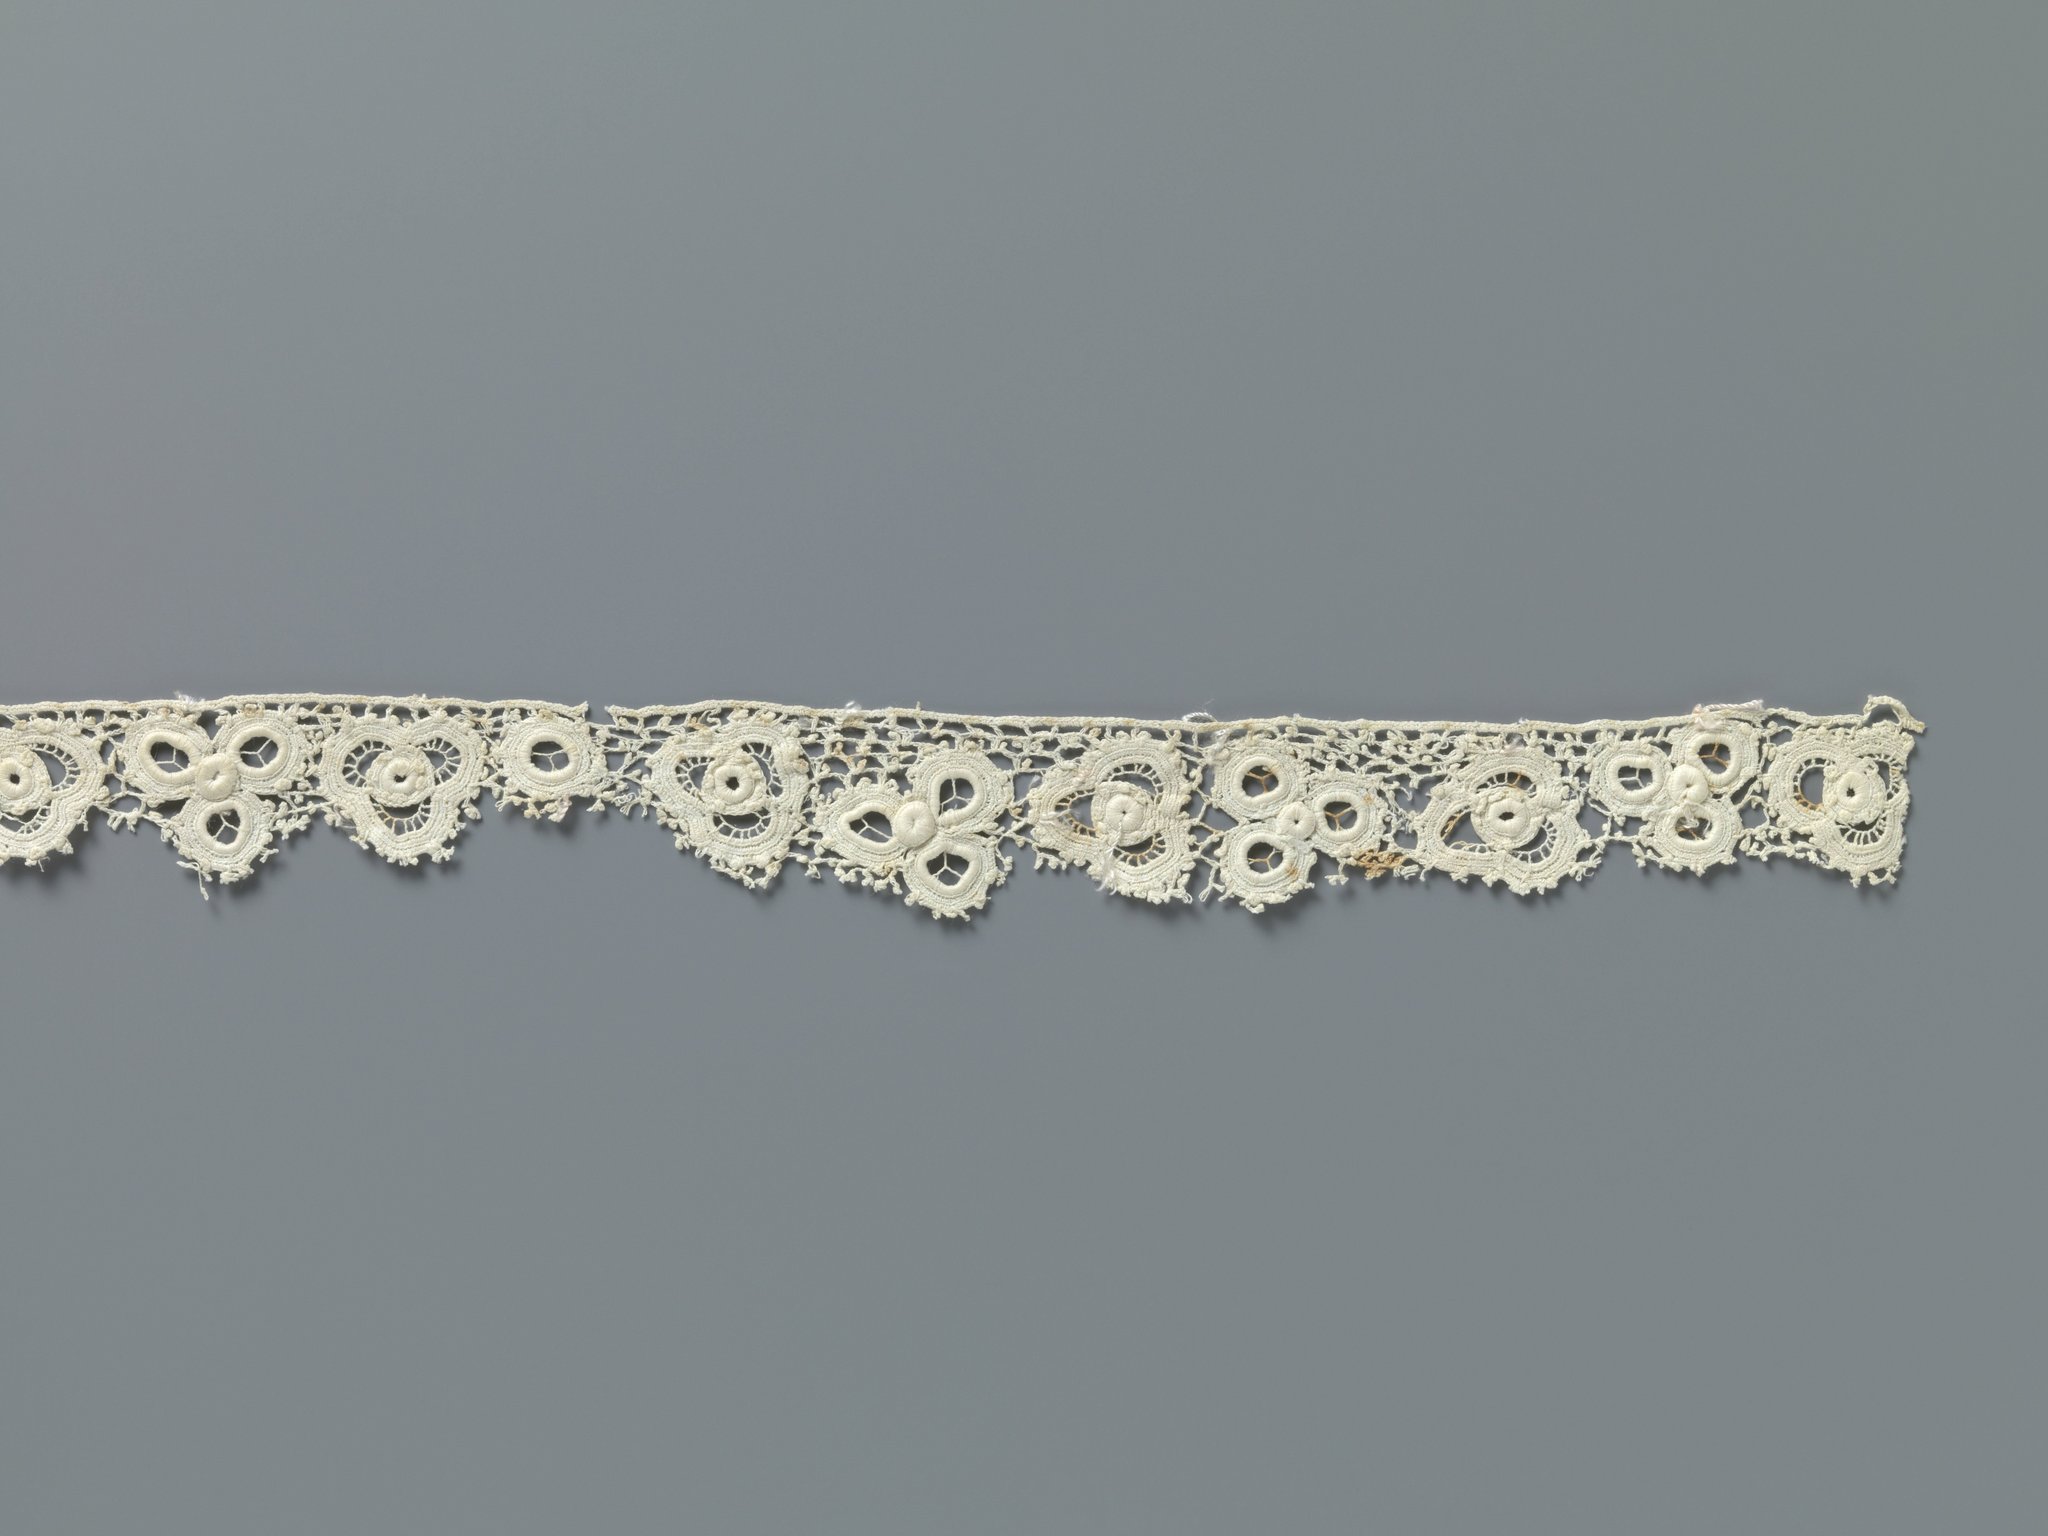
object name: strip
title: Strook gehaakte kant met driehoekig bloemmotief gemaakt met open cirkels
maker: Anonymous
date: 1890-1909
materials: cotton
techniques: crocheted lace, irish crochet lace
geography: ireland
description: Het is een aanname dat deze Ierse gehaakte kant ook daadwerkelijk in Ierland is gemaakt. Ierse gehaakte kant kent zijn oorsprong rond 1760 en kwam vanaf 1840 in ontwikkeling. Aangezien volgens Martine Bruggeman (Kant in Europa) de Ierse haakindustrie aan het eind van de 19e eeuw gereorganiseerd werd en in populariteit groeide, is het hier beschreven stuk gedateerd rond 1890, tot 1909 vanwege de datering in het eerste decennium van populariteit van Ierse gehaakte kant volgens het Kantlexicon (Johan Coene).